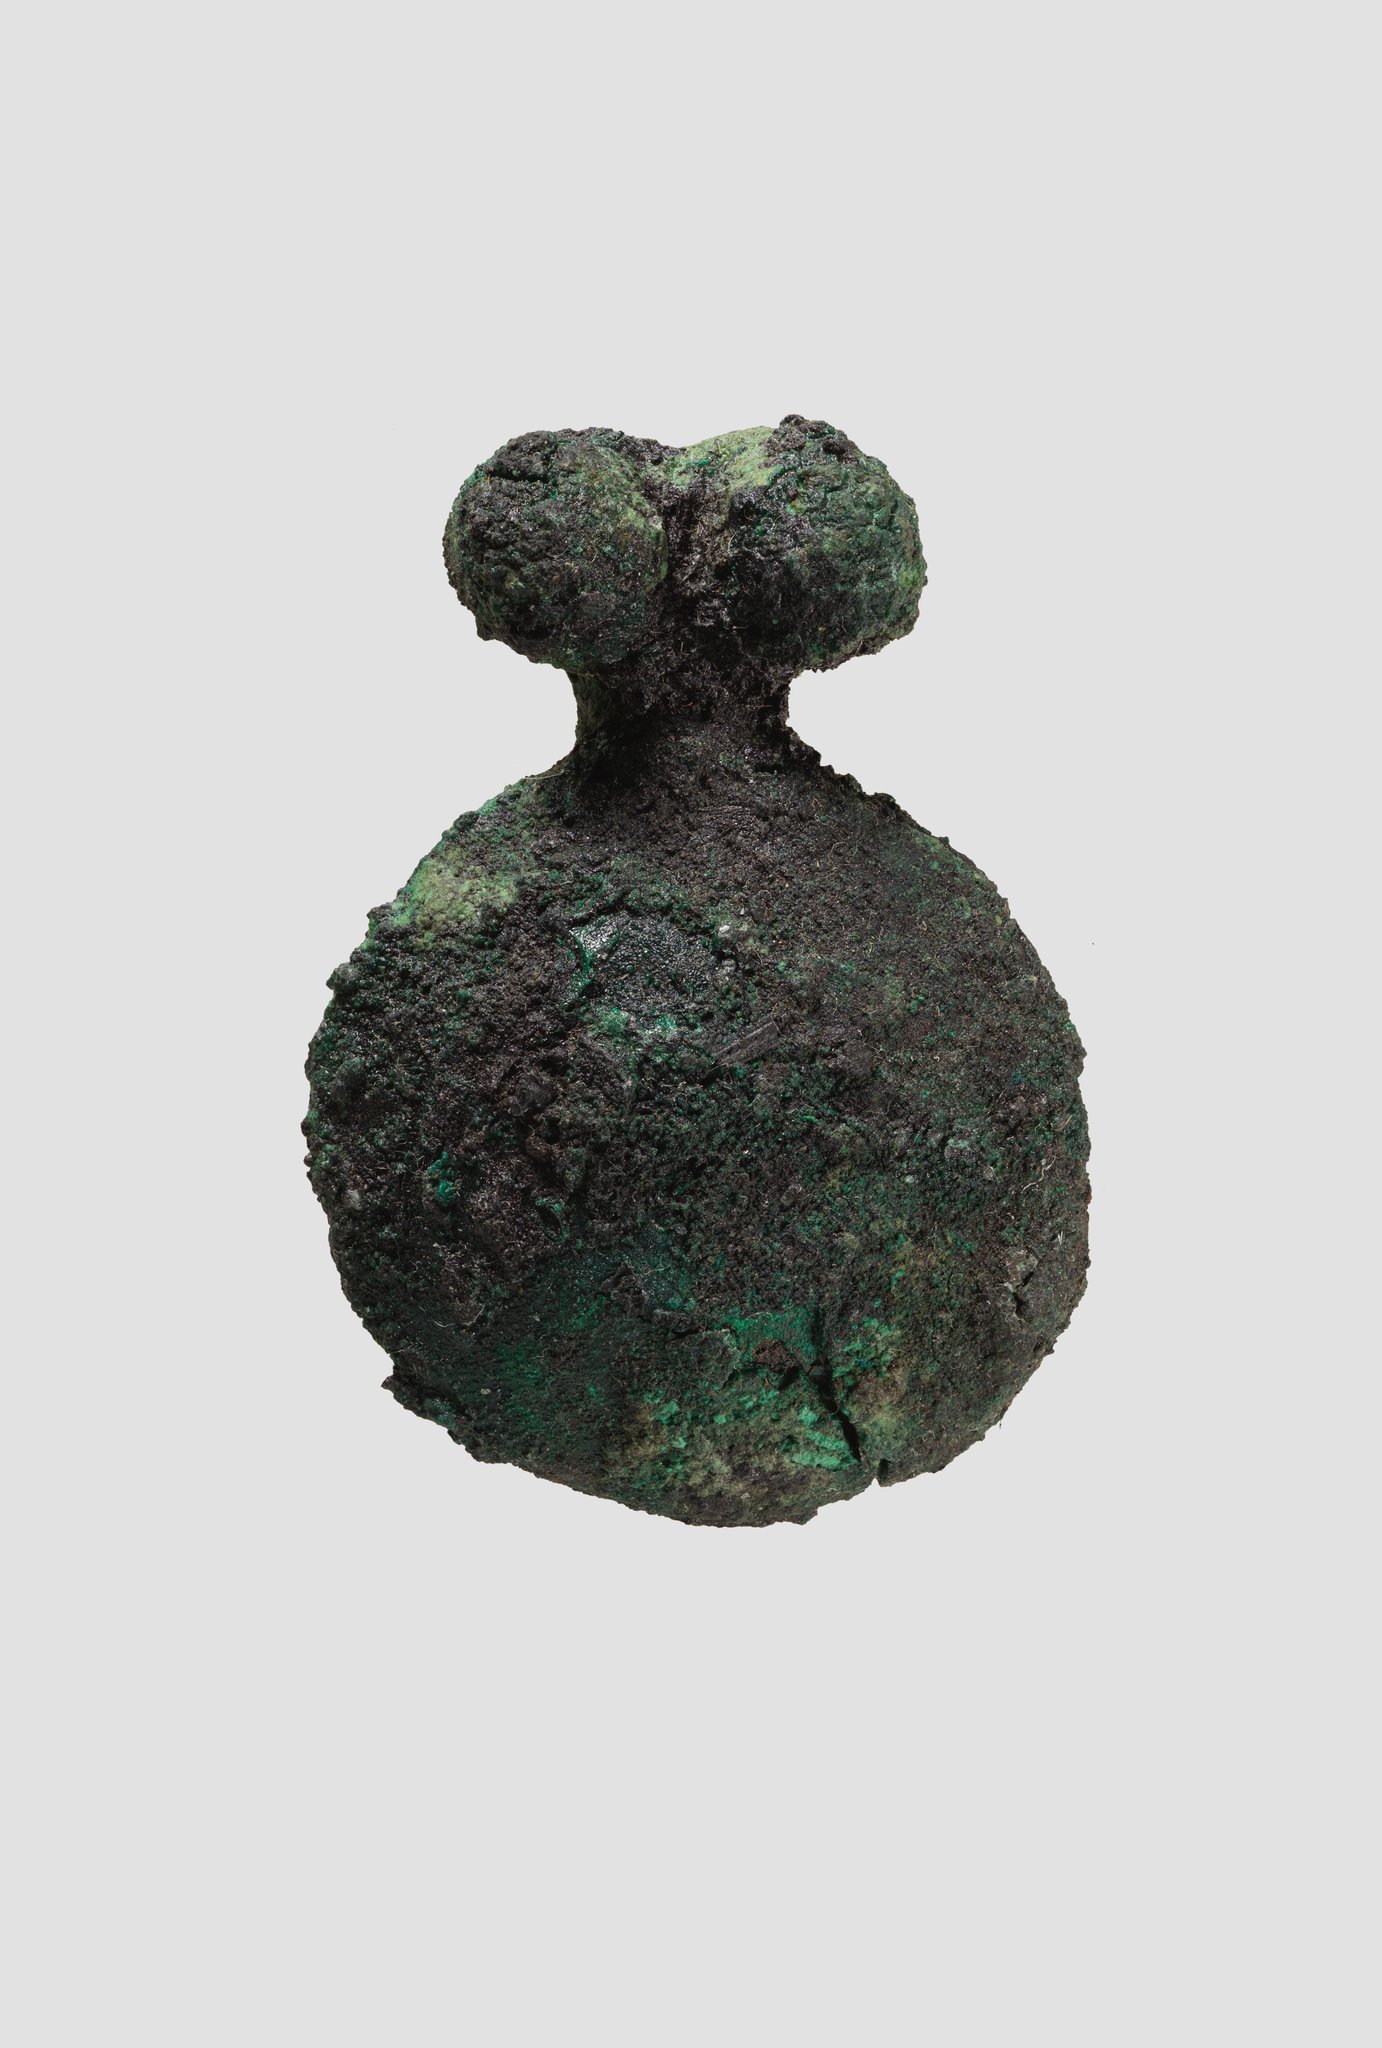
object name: ornament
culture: iranian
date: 900-801 BCE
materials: bronze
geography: iran